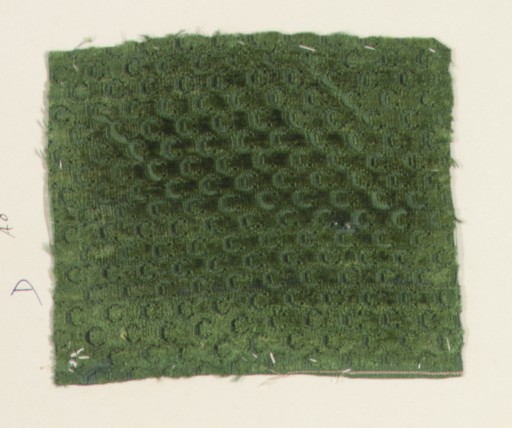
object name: fragment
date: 1501-1600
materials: silk